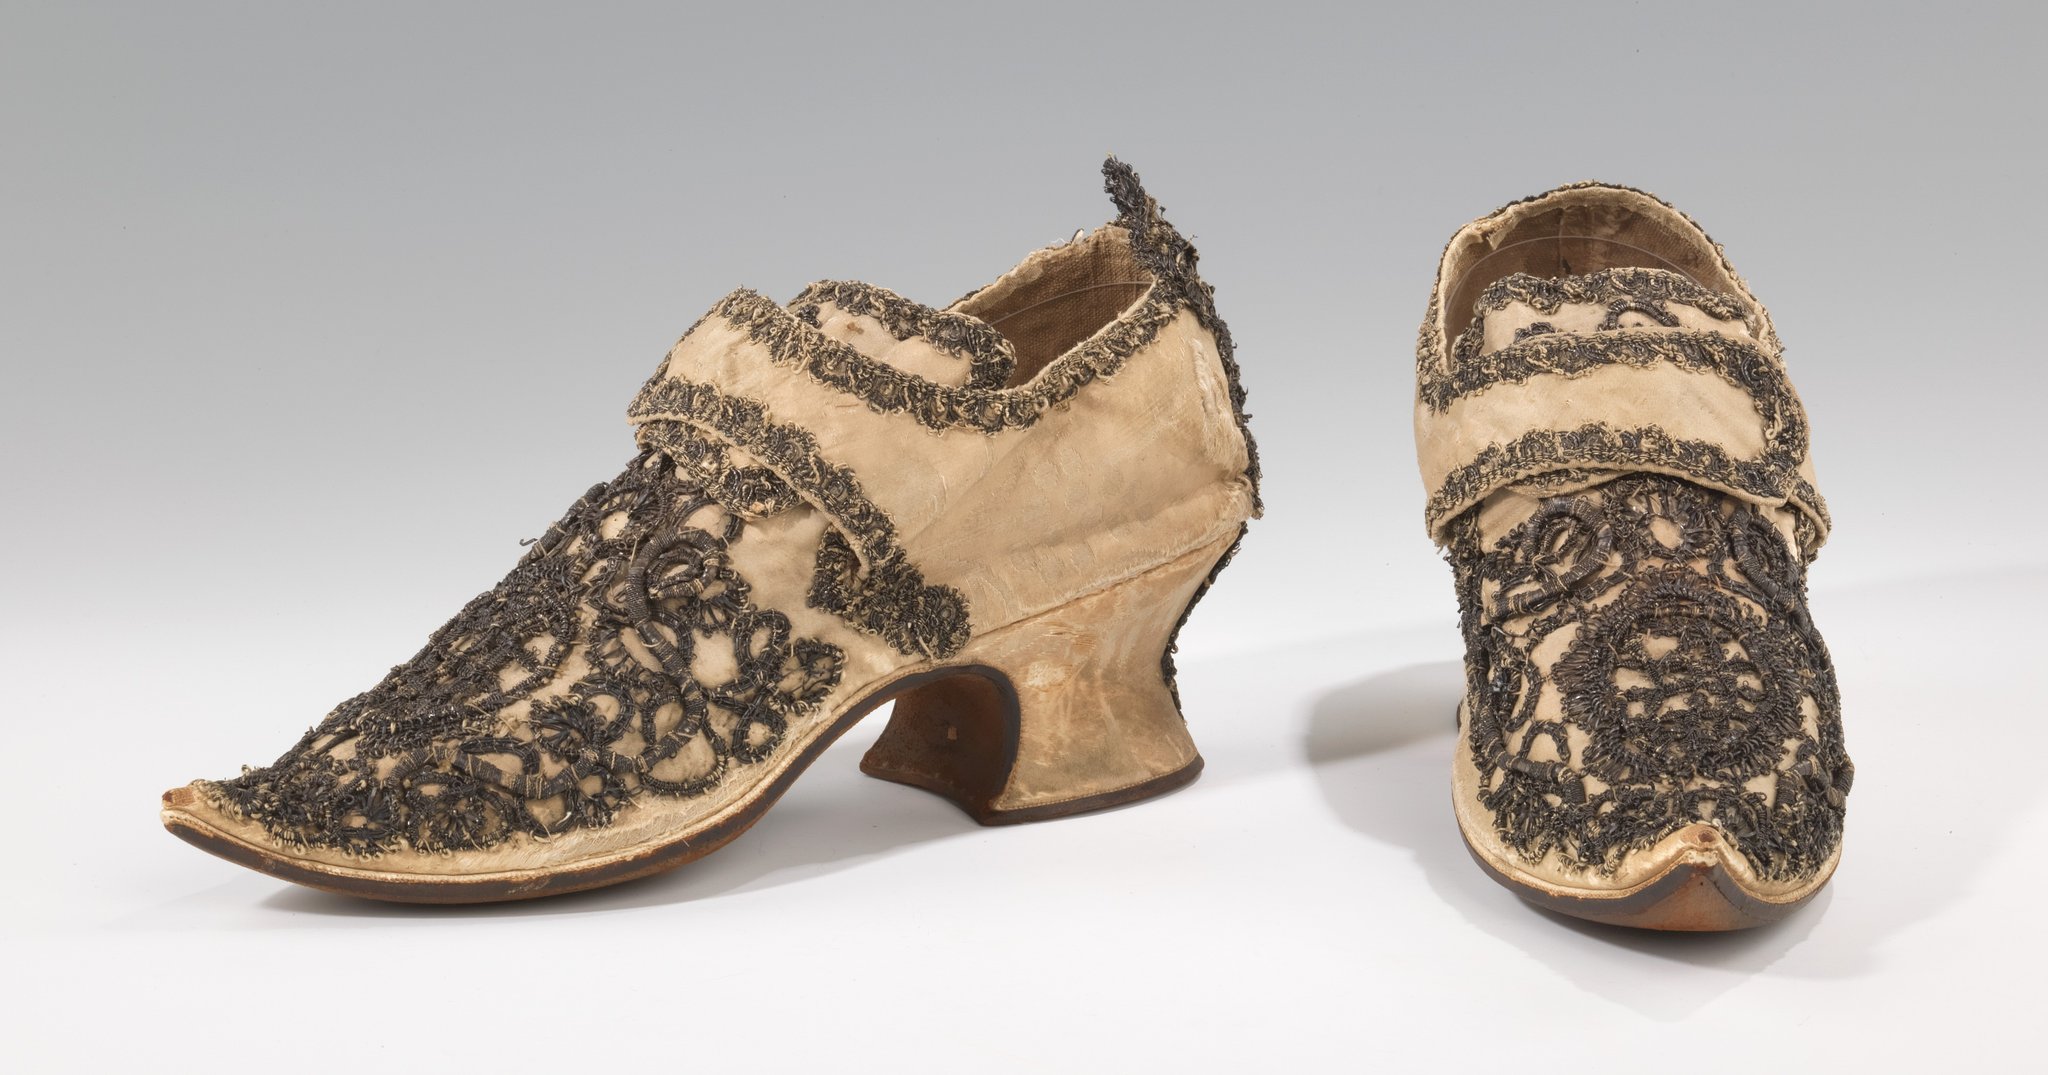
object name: shoe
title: Shoes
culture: british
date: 1690-1729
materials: metal, silk